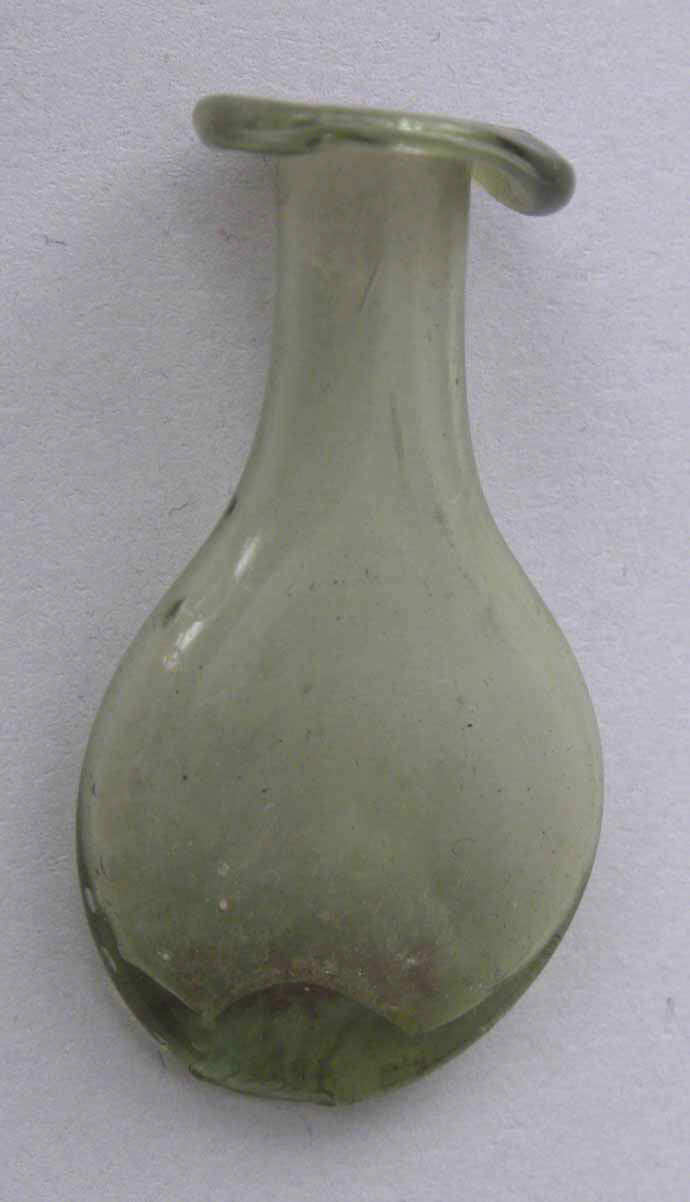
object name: bottle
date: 801-1100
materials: glass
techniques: glassblowing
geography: egypt